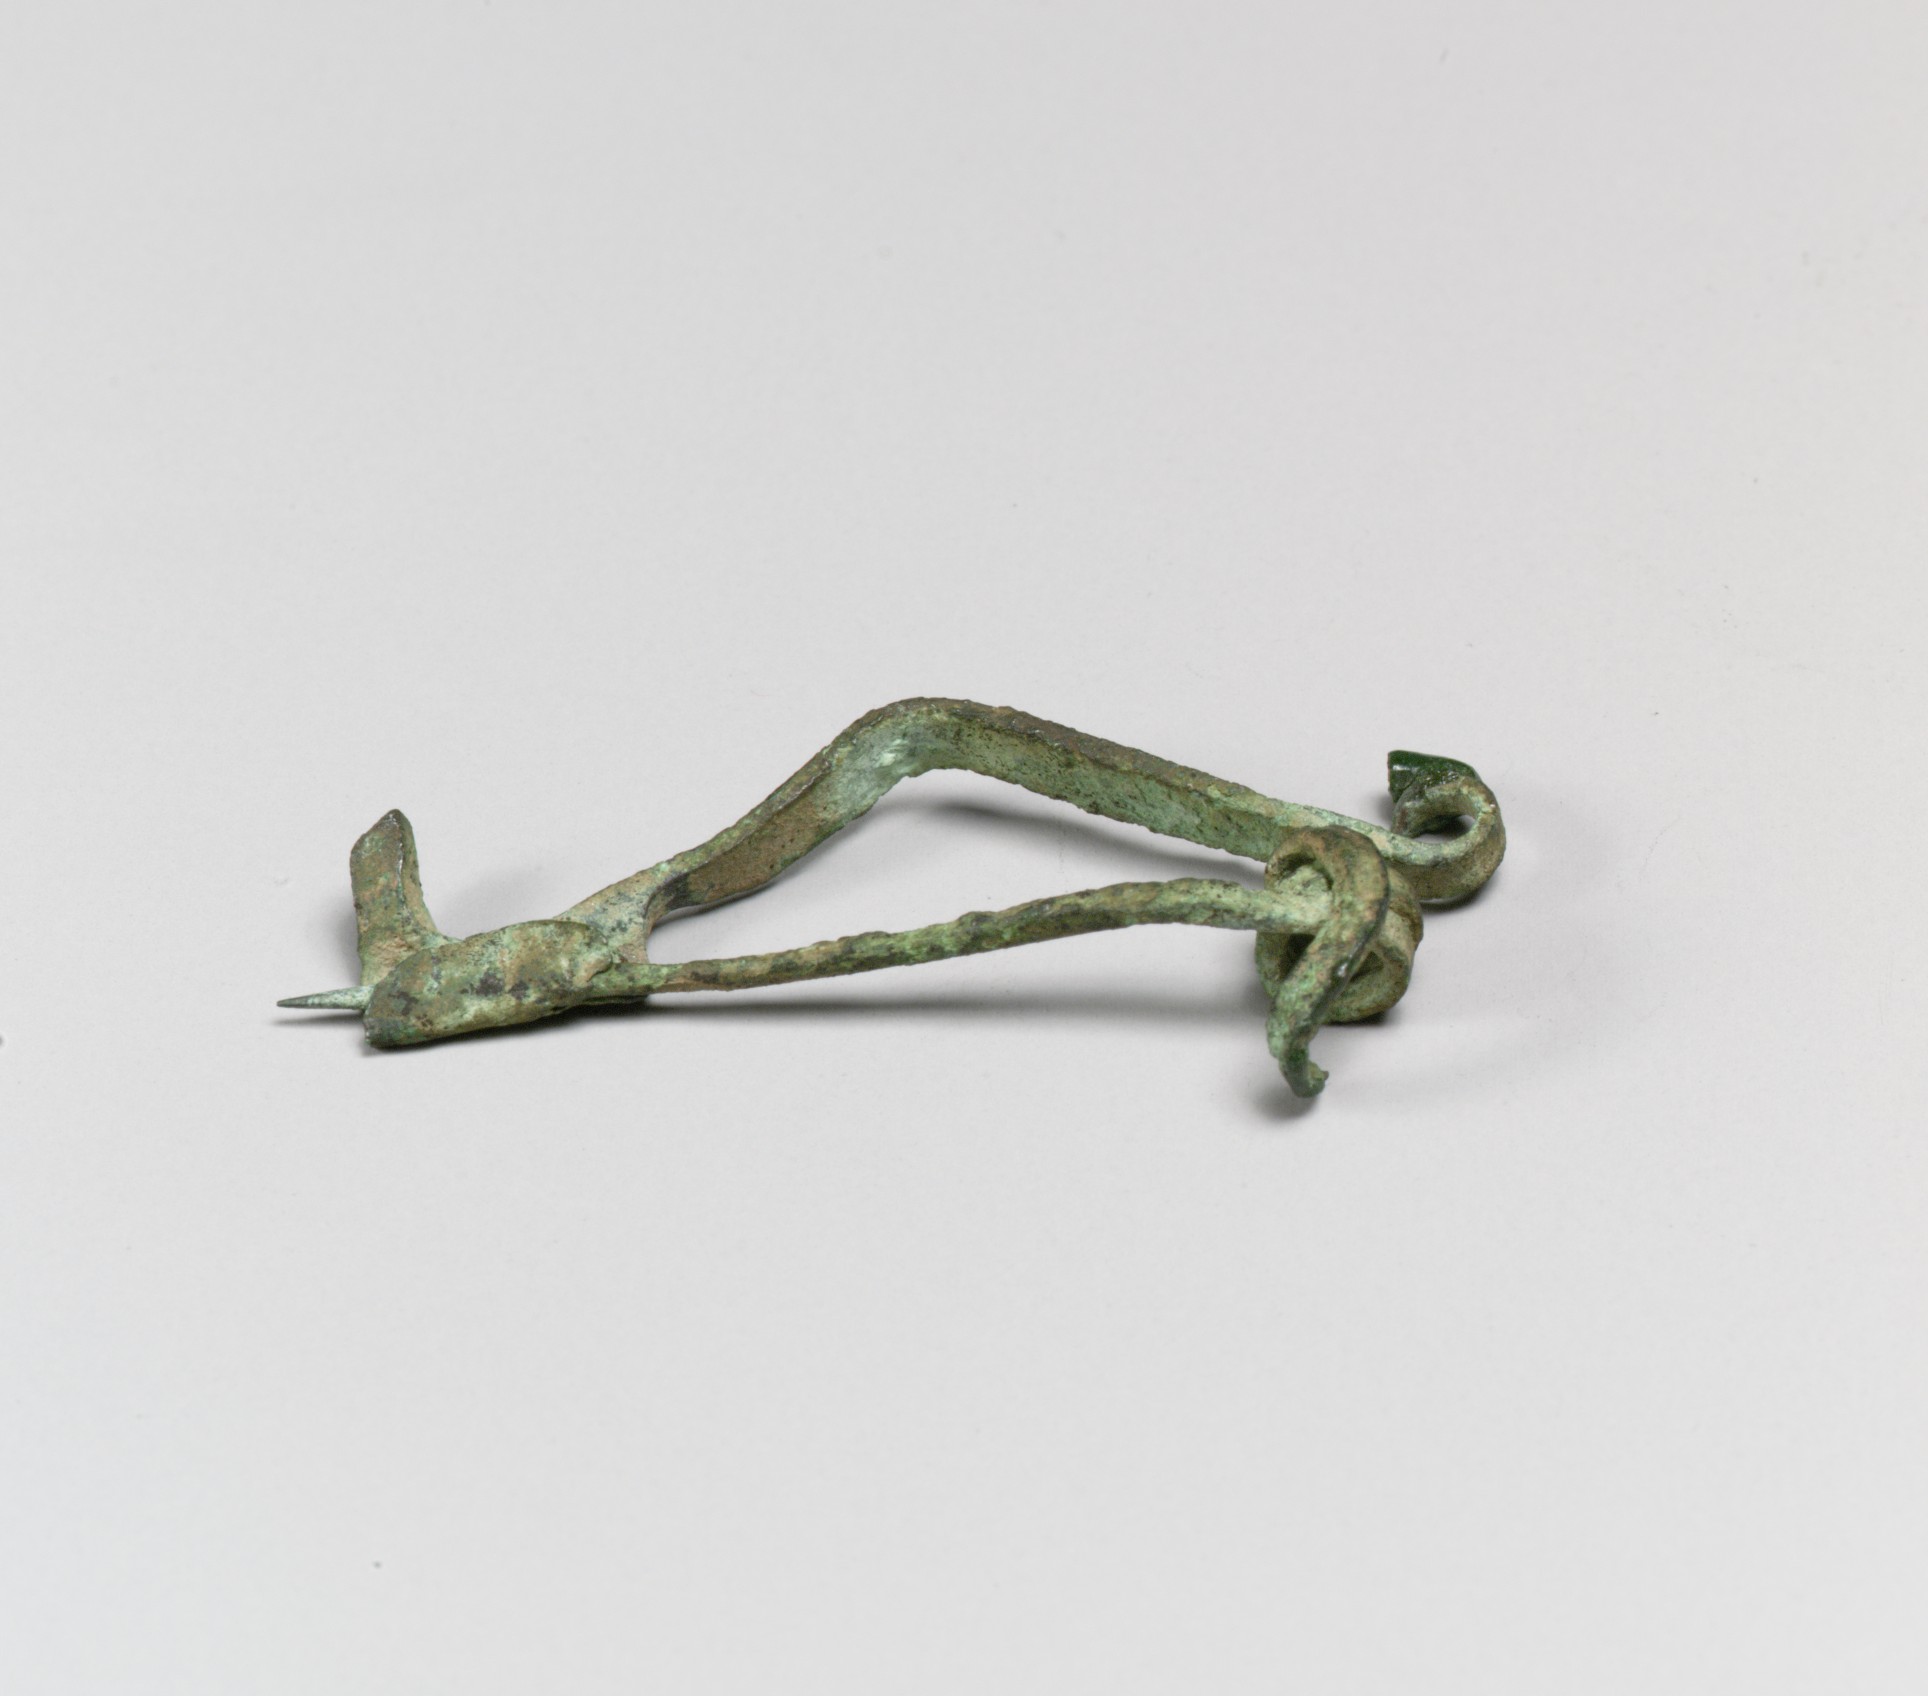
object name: fibula, la tene type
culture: italic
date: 600-401 BCE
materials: bronze